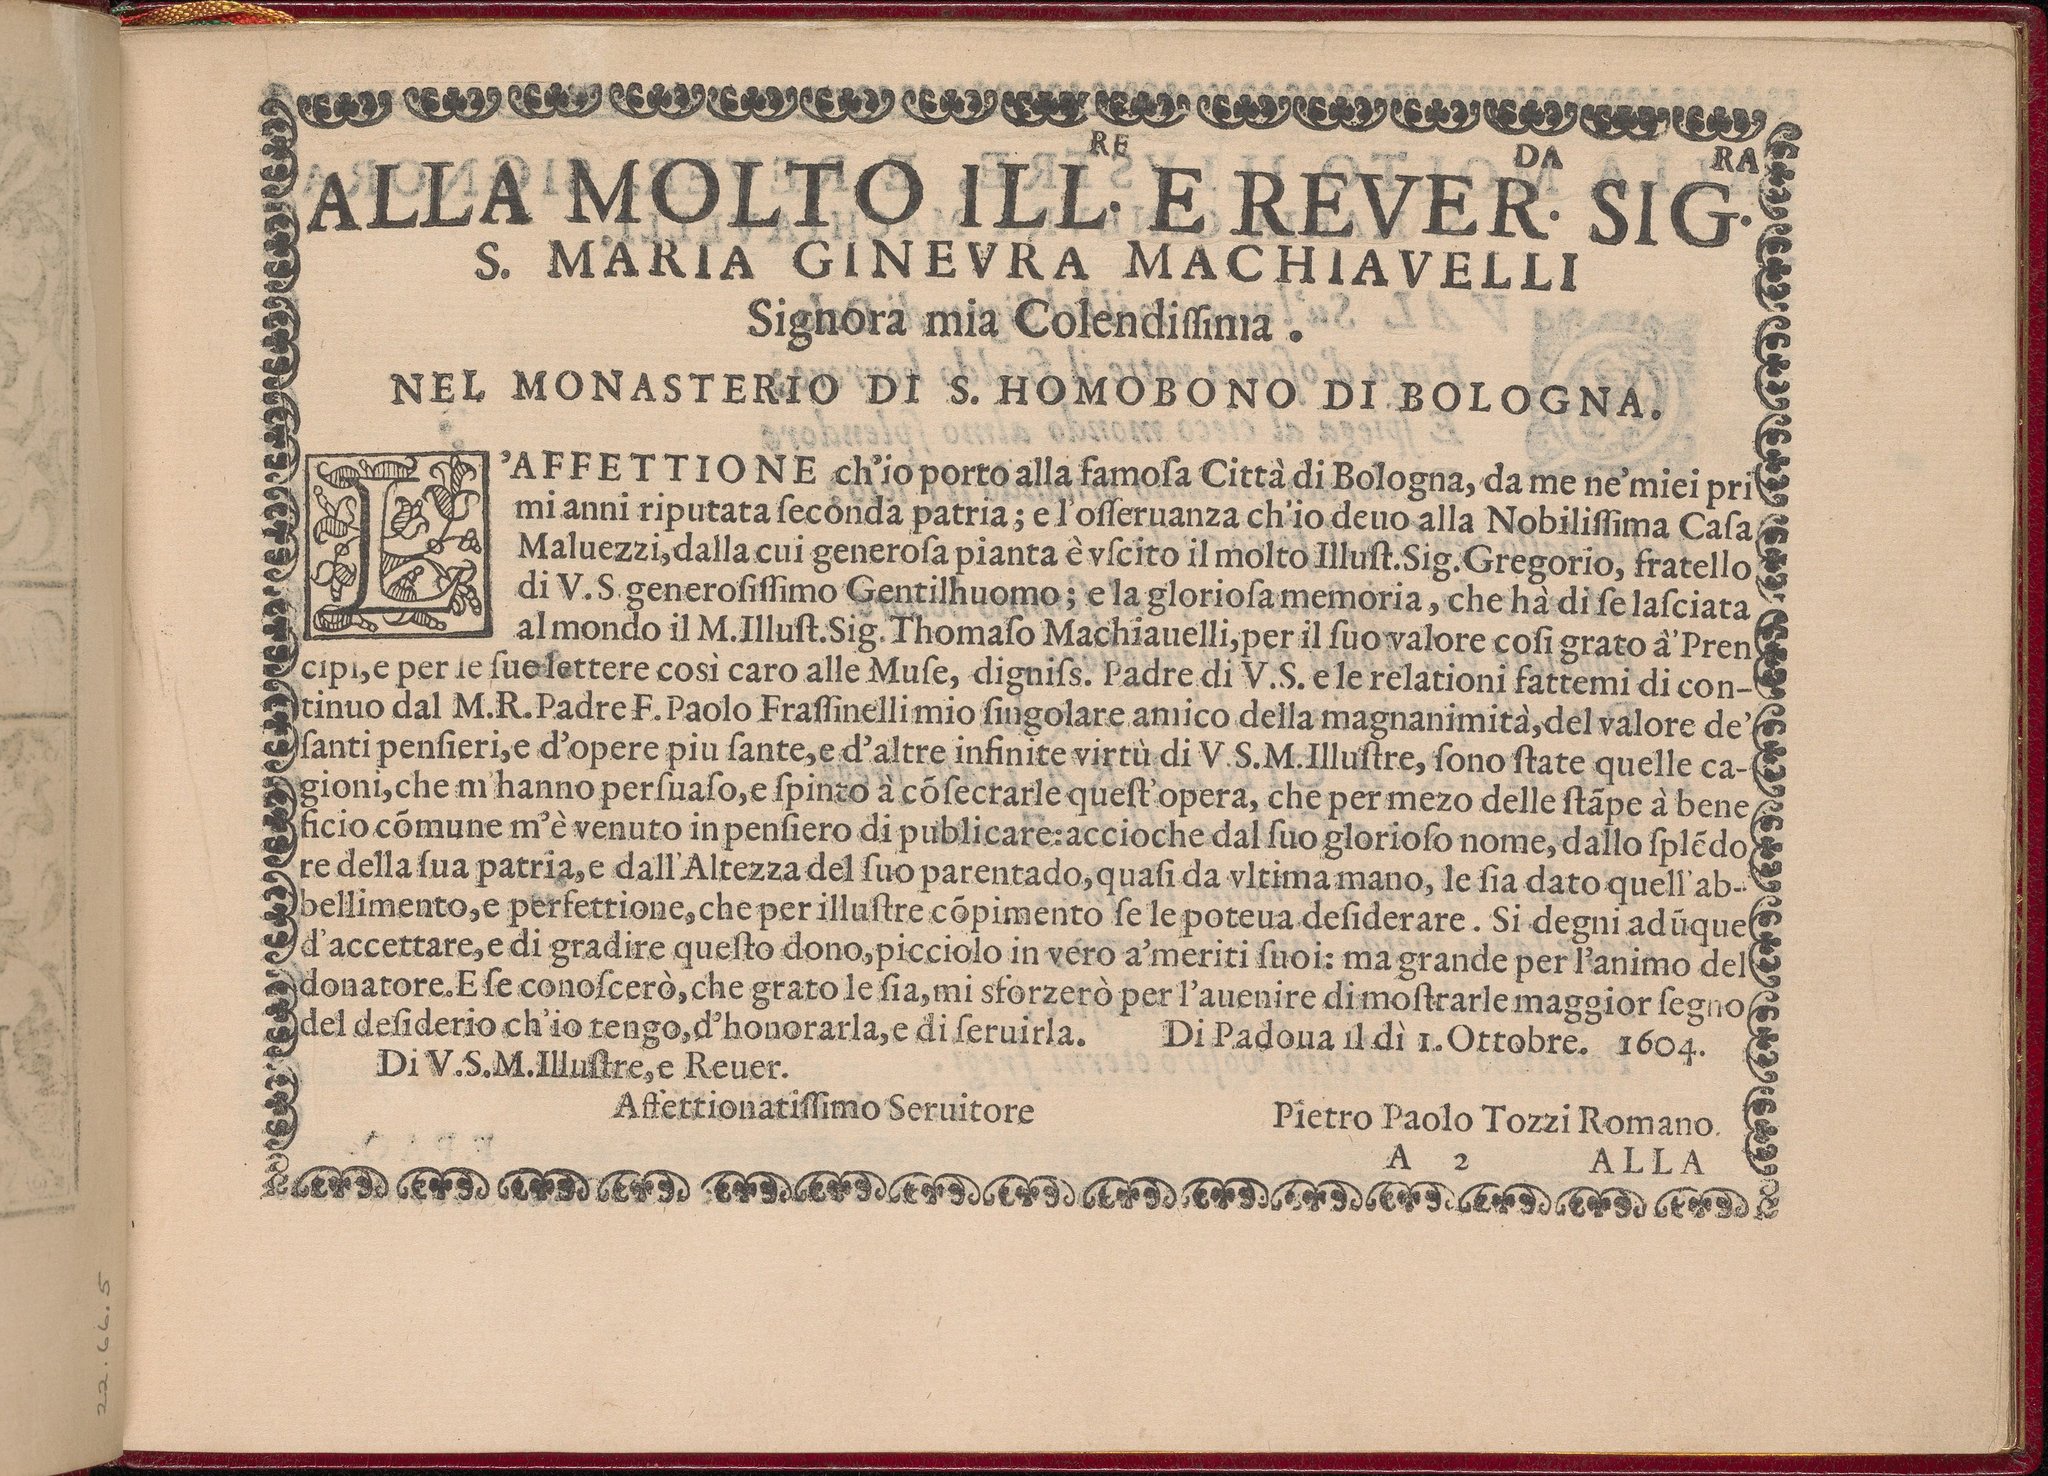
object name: book print ornament architecture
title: Ghirlanda: Di sei vaghi fiori scielti da piu famosi Giardini d'Italia, page 2 (recto)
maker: pietro paulo tozzi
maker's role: designer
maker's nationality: italian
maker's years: 1593-1628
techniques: drawing, etching